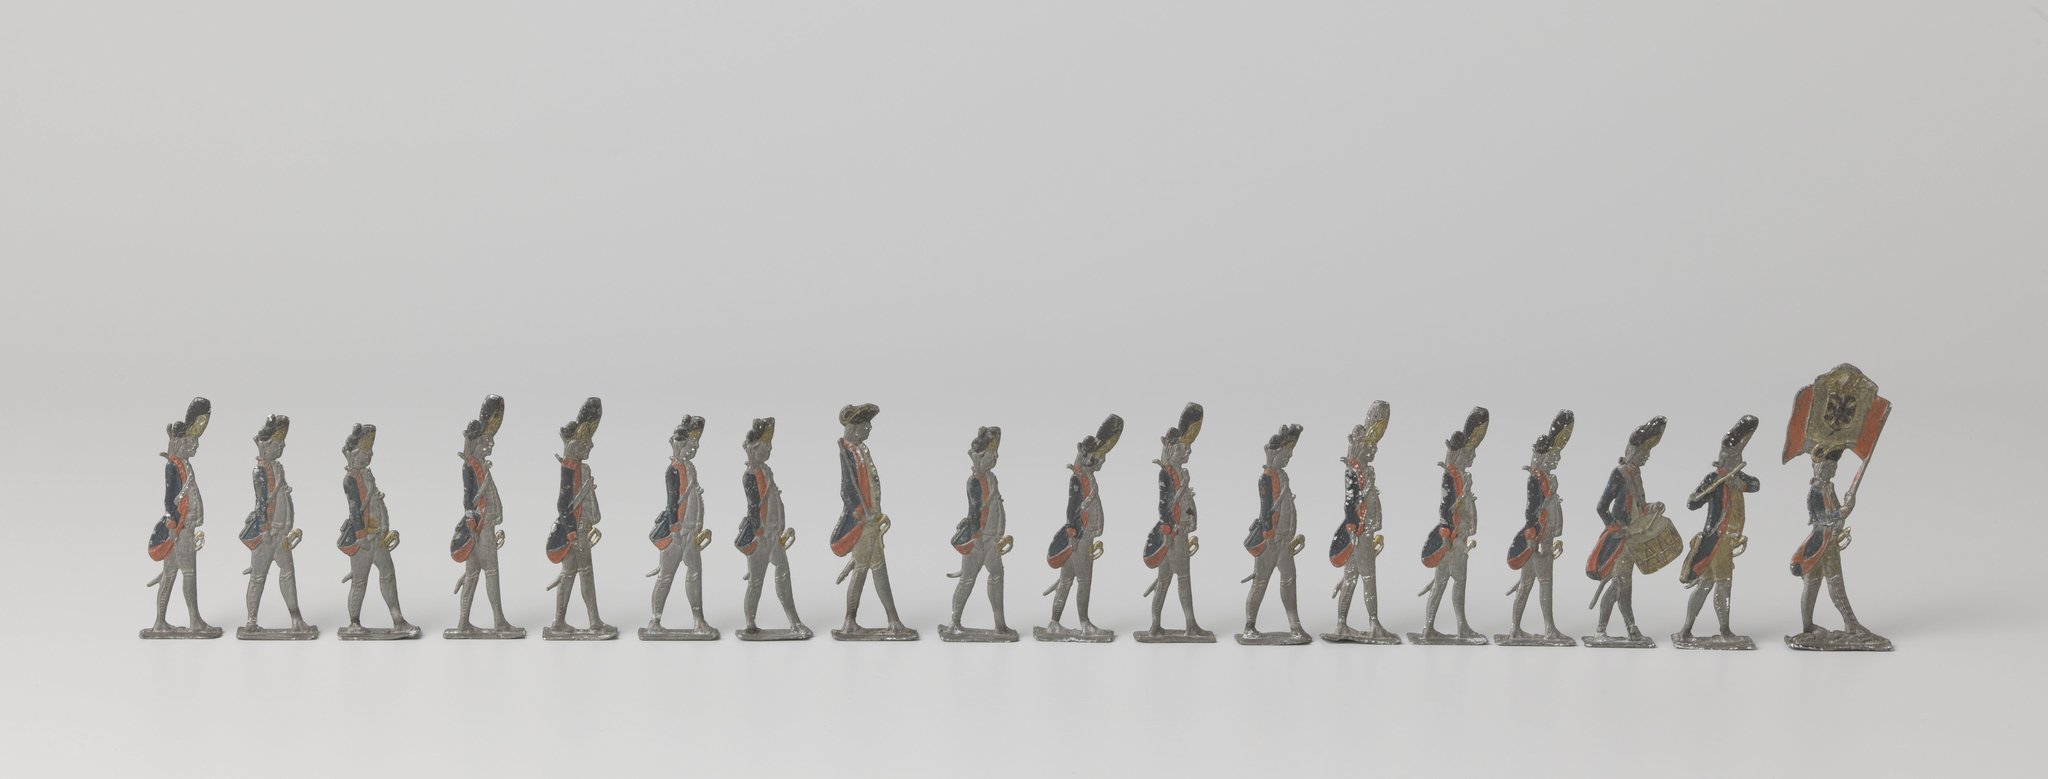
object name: toy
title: Tinnen soldaatjes in Pruissisch uniform uit de tijd van Frederik de grote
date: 1700-1800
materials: tin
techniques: casting, polychromy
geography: germany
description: Collectie tinnen soldaatjes bestaande uit 18 man voetvolk, waaronder één officier, één vaandeldrager, één fluitspeler en één tamboer; 8 man ruiterij, waaronder één met trompet en één met trommels: van de laatste de voet afgebroken en de armen beschadigd. Kleuren: grijs (tin), blauw, rood, zwart en goud.